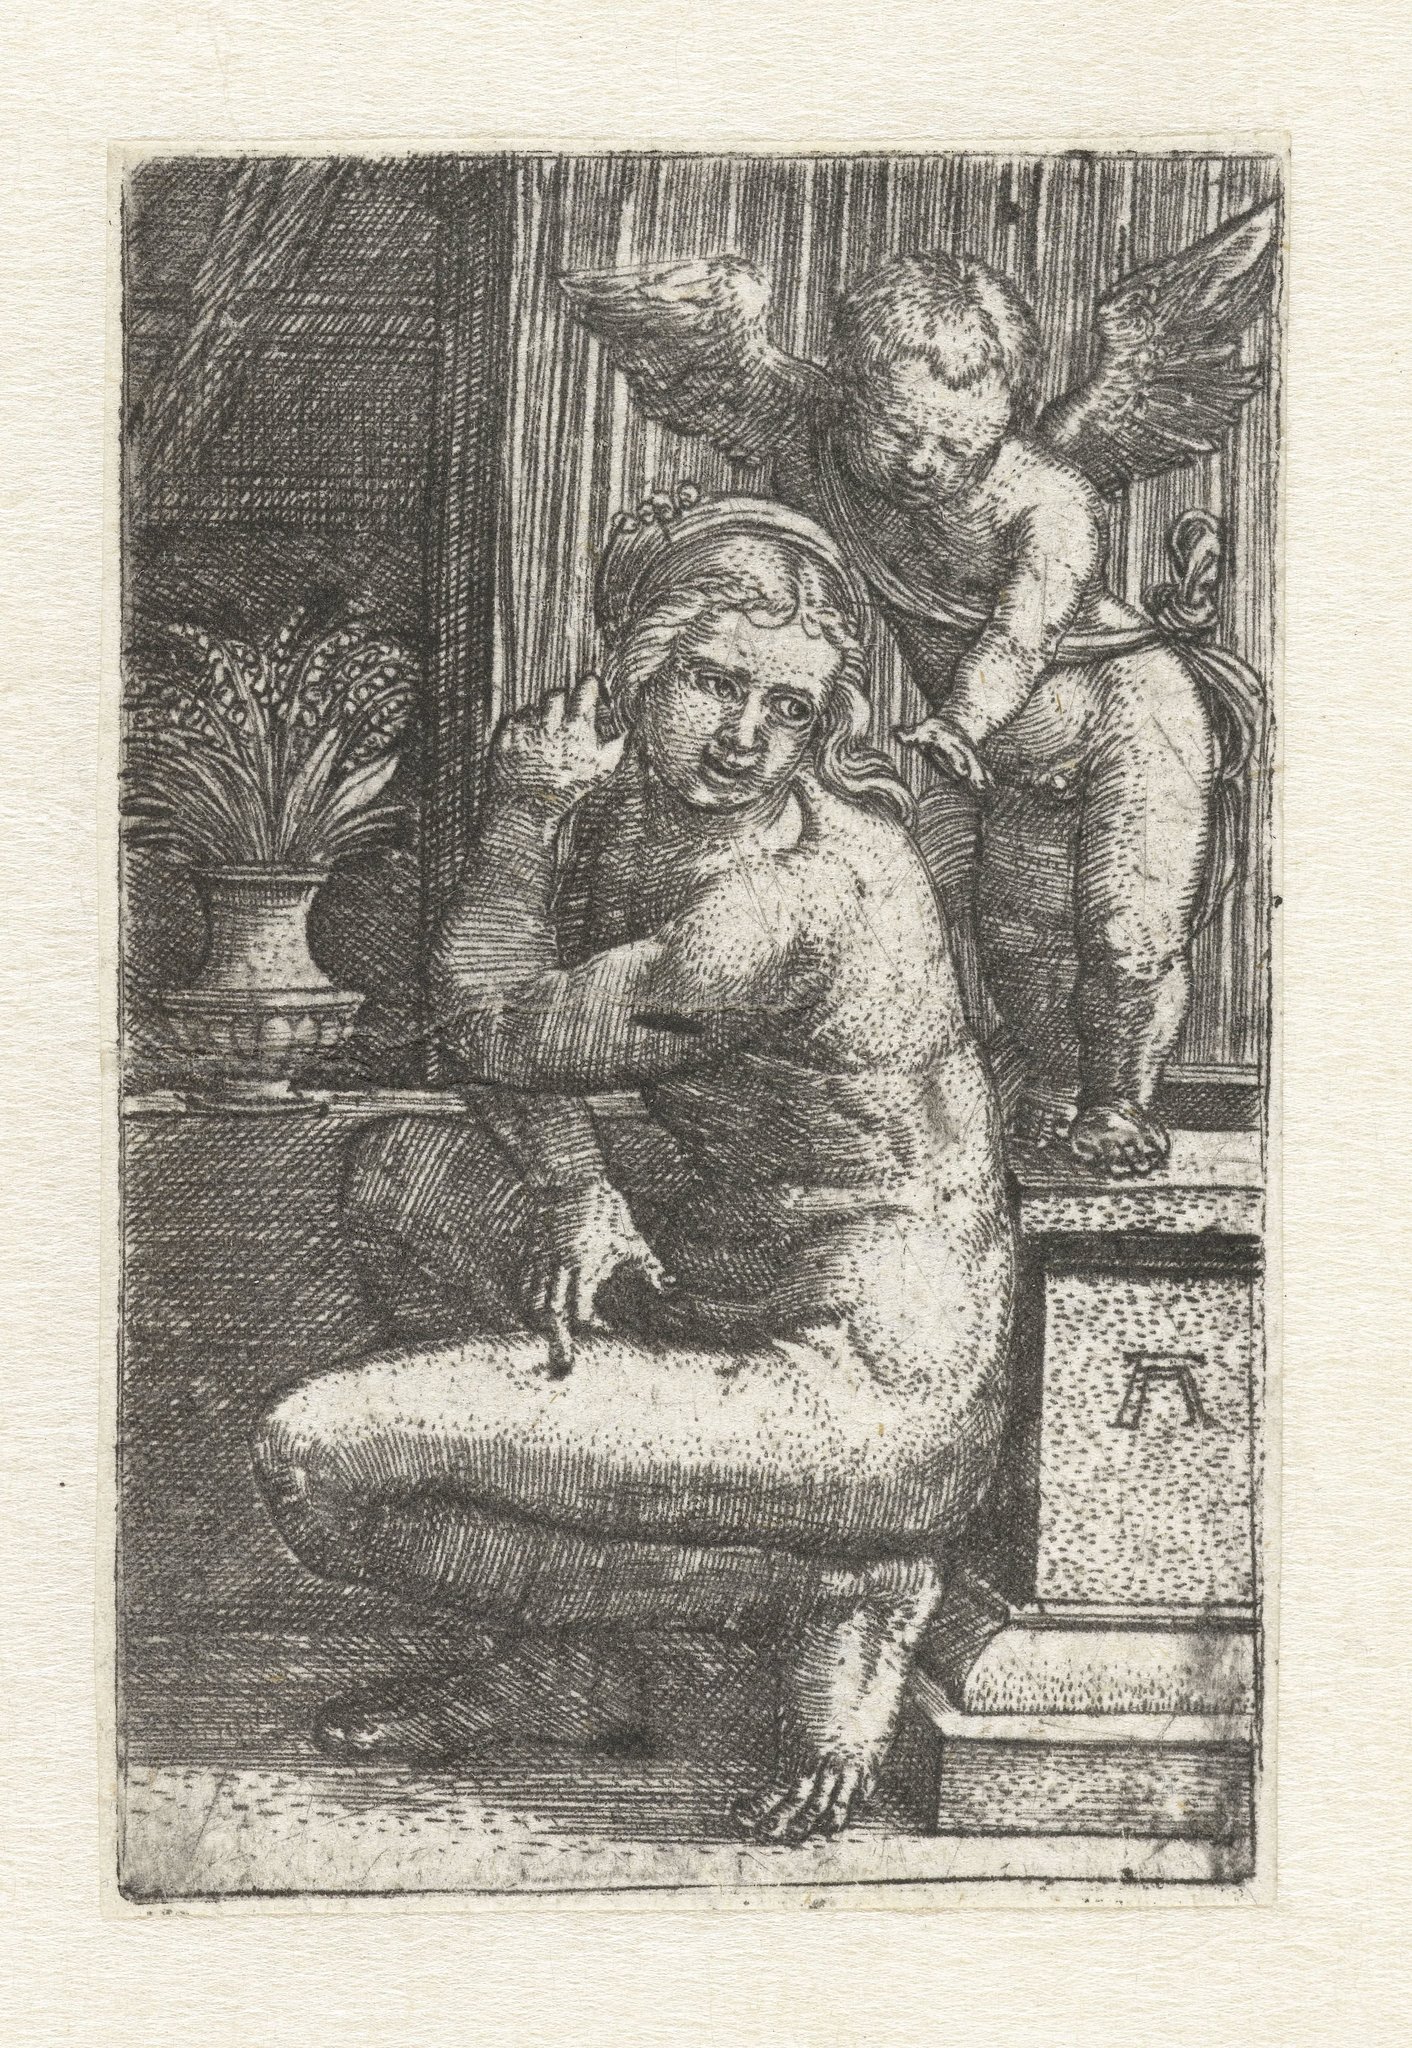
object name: print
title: Knielende Venus met Cupido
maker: albrecht altdorfer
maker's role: draughtsman, print maker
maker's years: 1480-1538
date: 1506-1538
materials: paper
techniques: engraving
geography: germany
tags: venus and cupid (cupid not being mere attribute)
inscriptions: number: ‘17’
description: Venus, van de zijkant gezien, geknield en leunend tegen een piëdestal waarop Cupido staat.